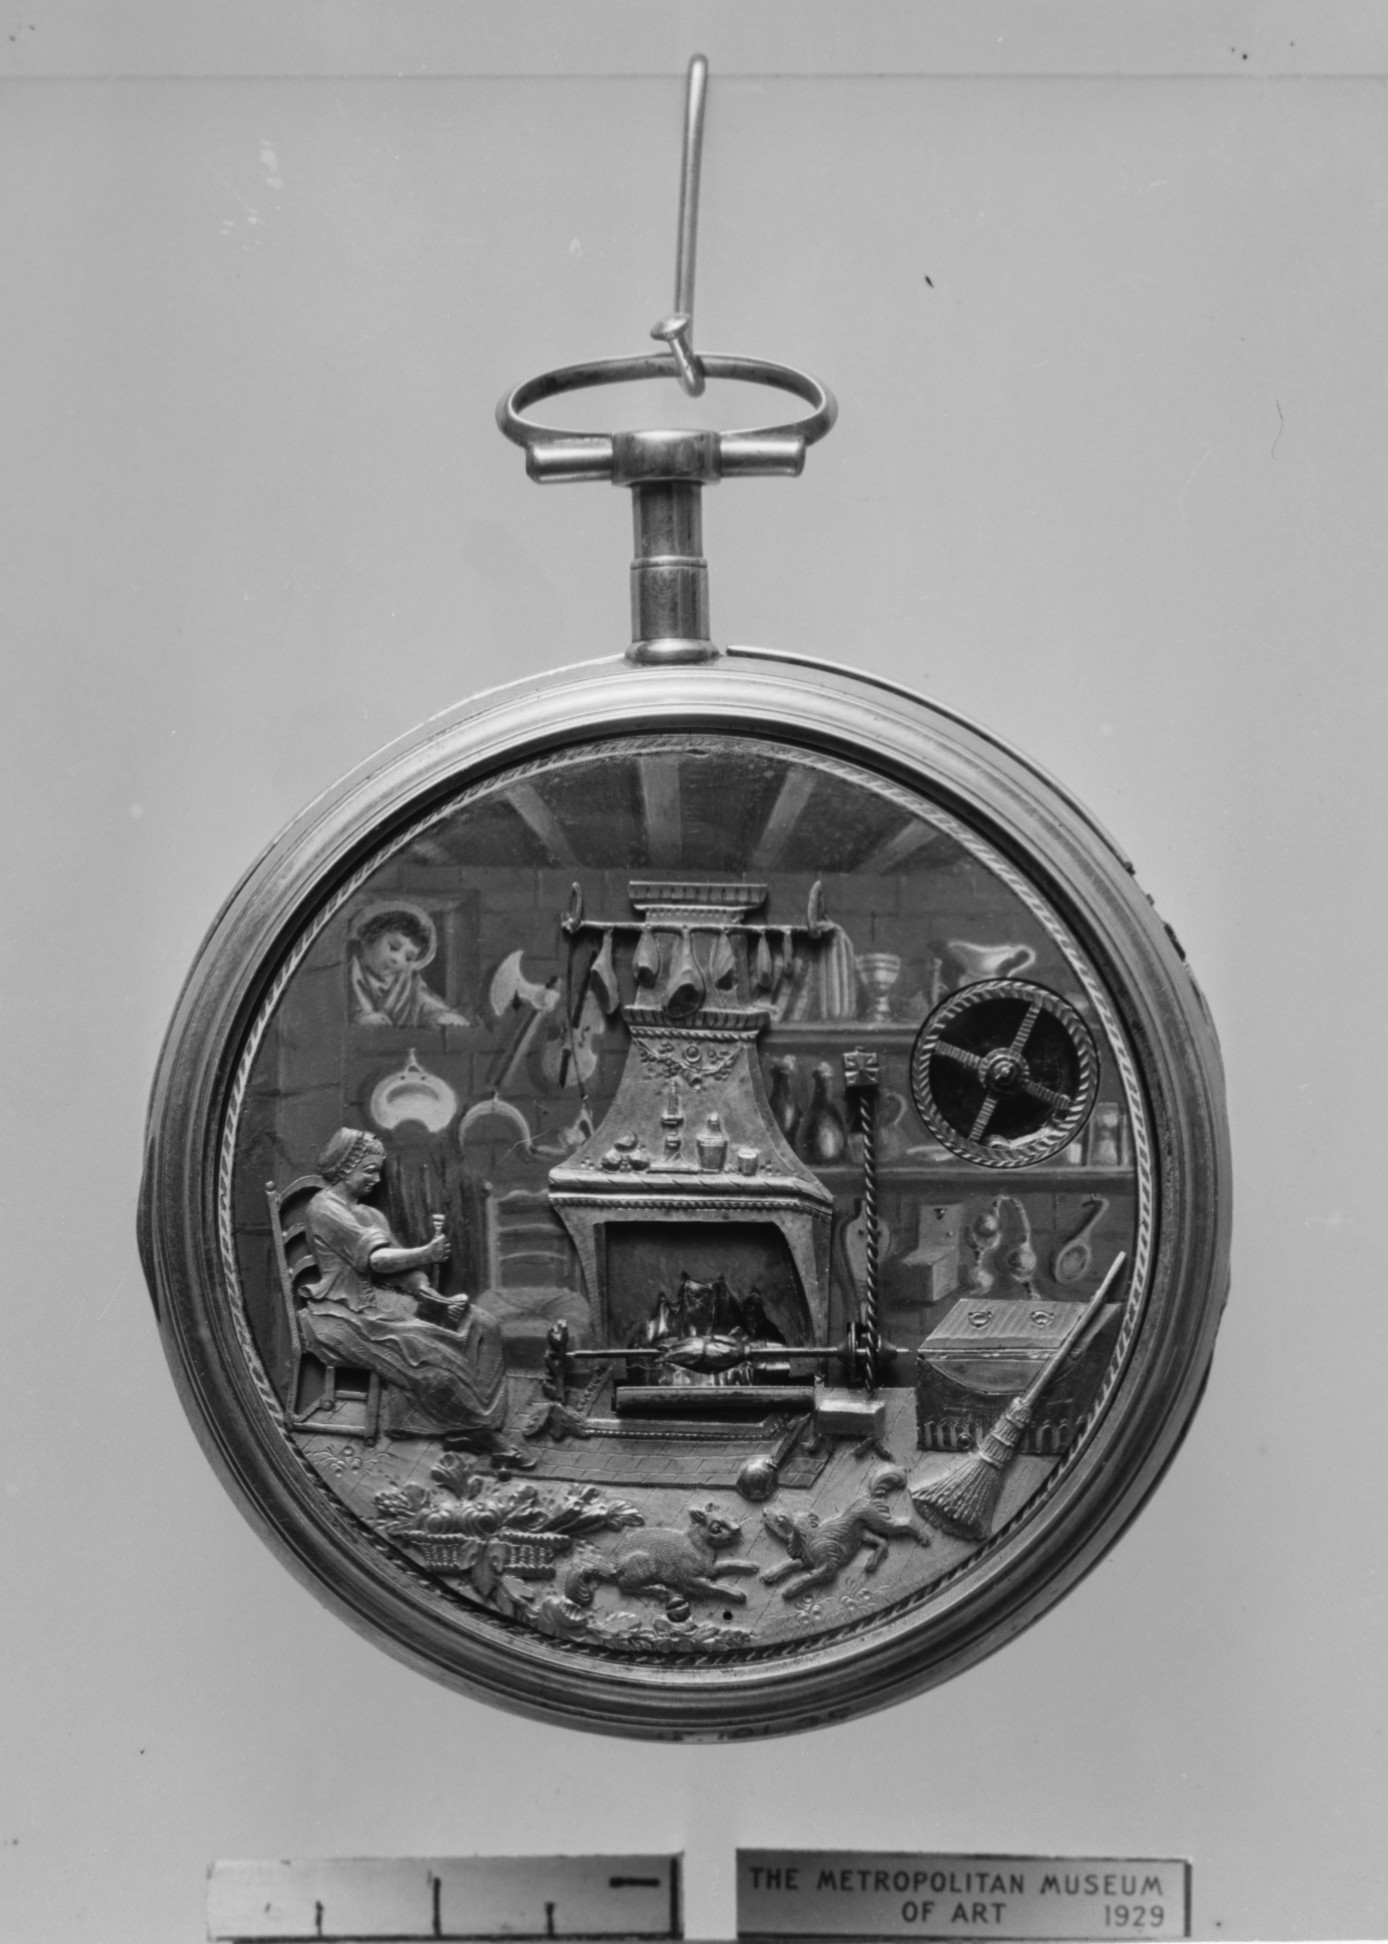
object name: repeating watch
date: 1801-1833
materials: gold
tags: interiors,women